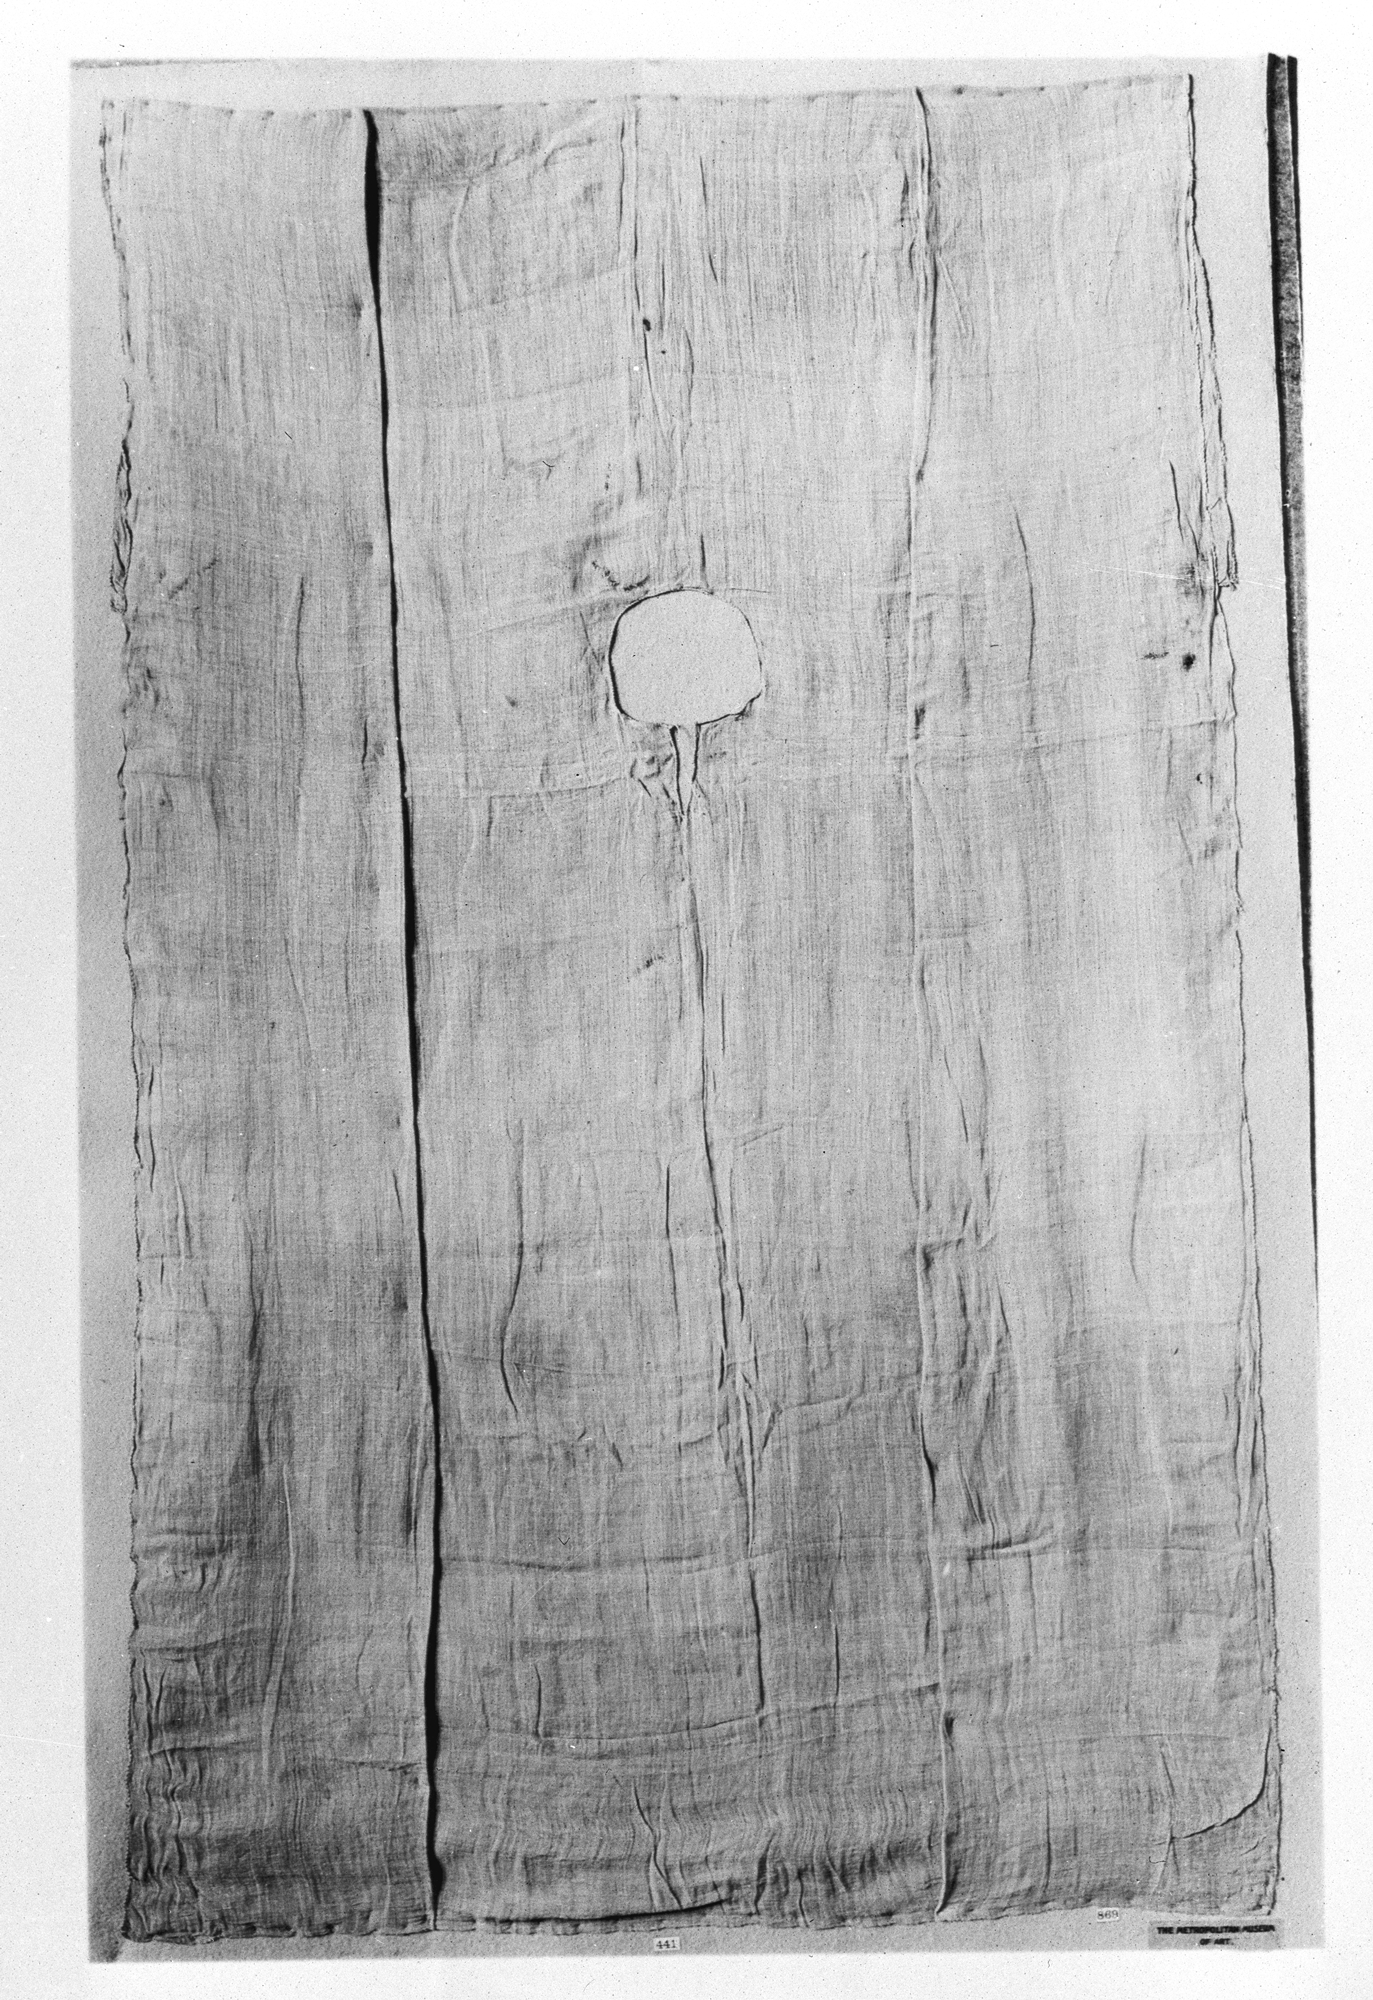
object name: shirt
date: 1550-1295 BCE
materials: linen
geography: egypt